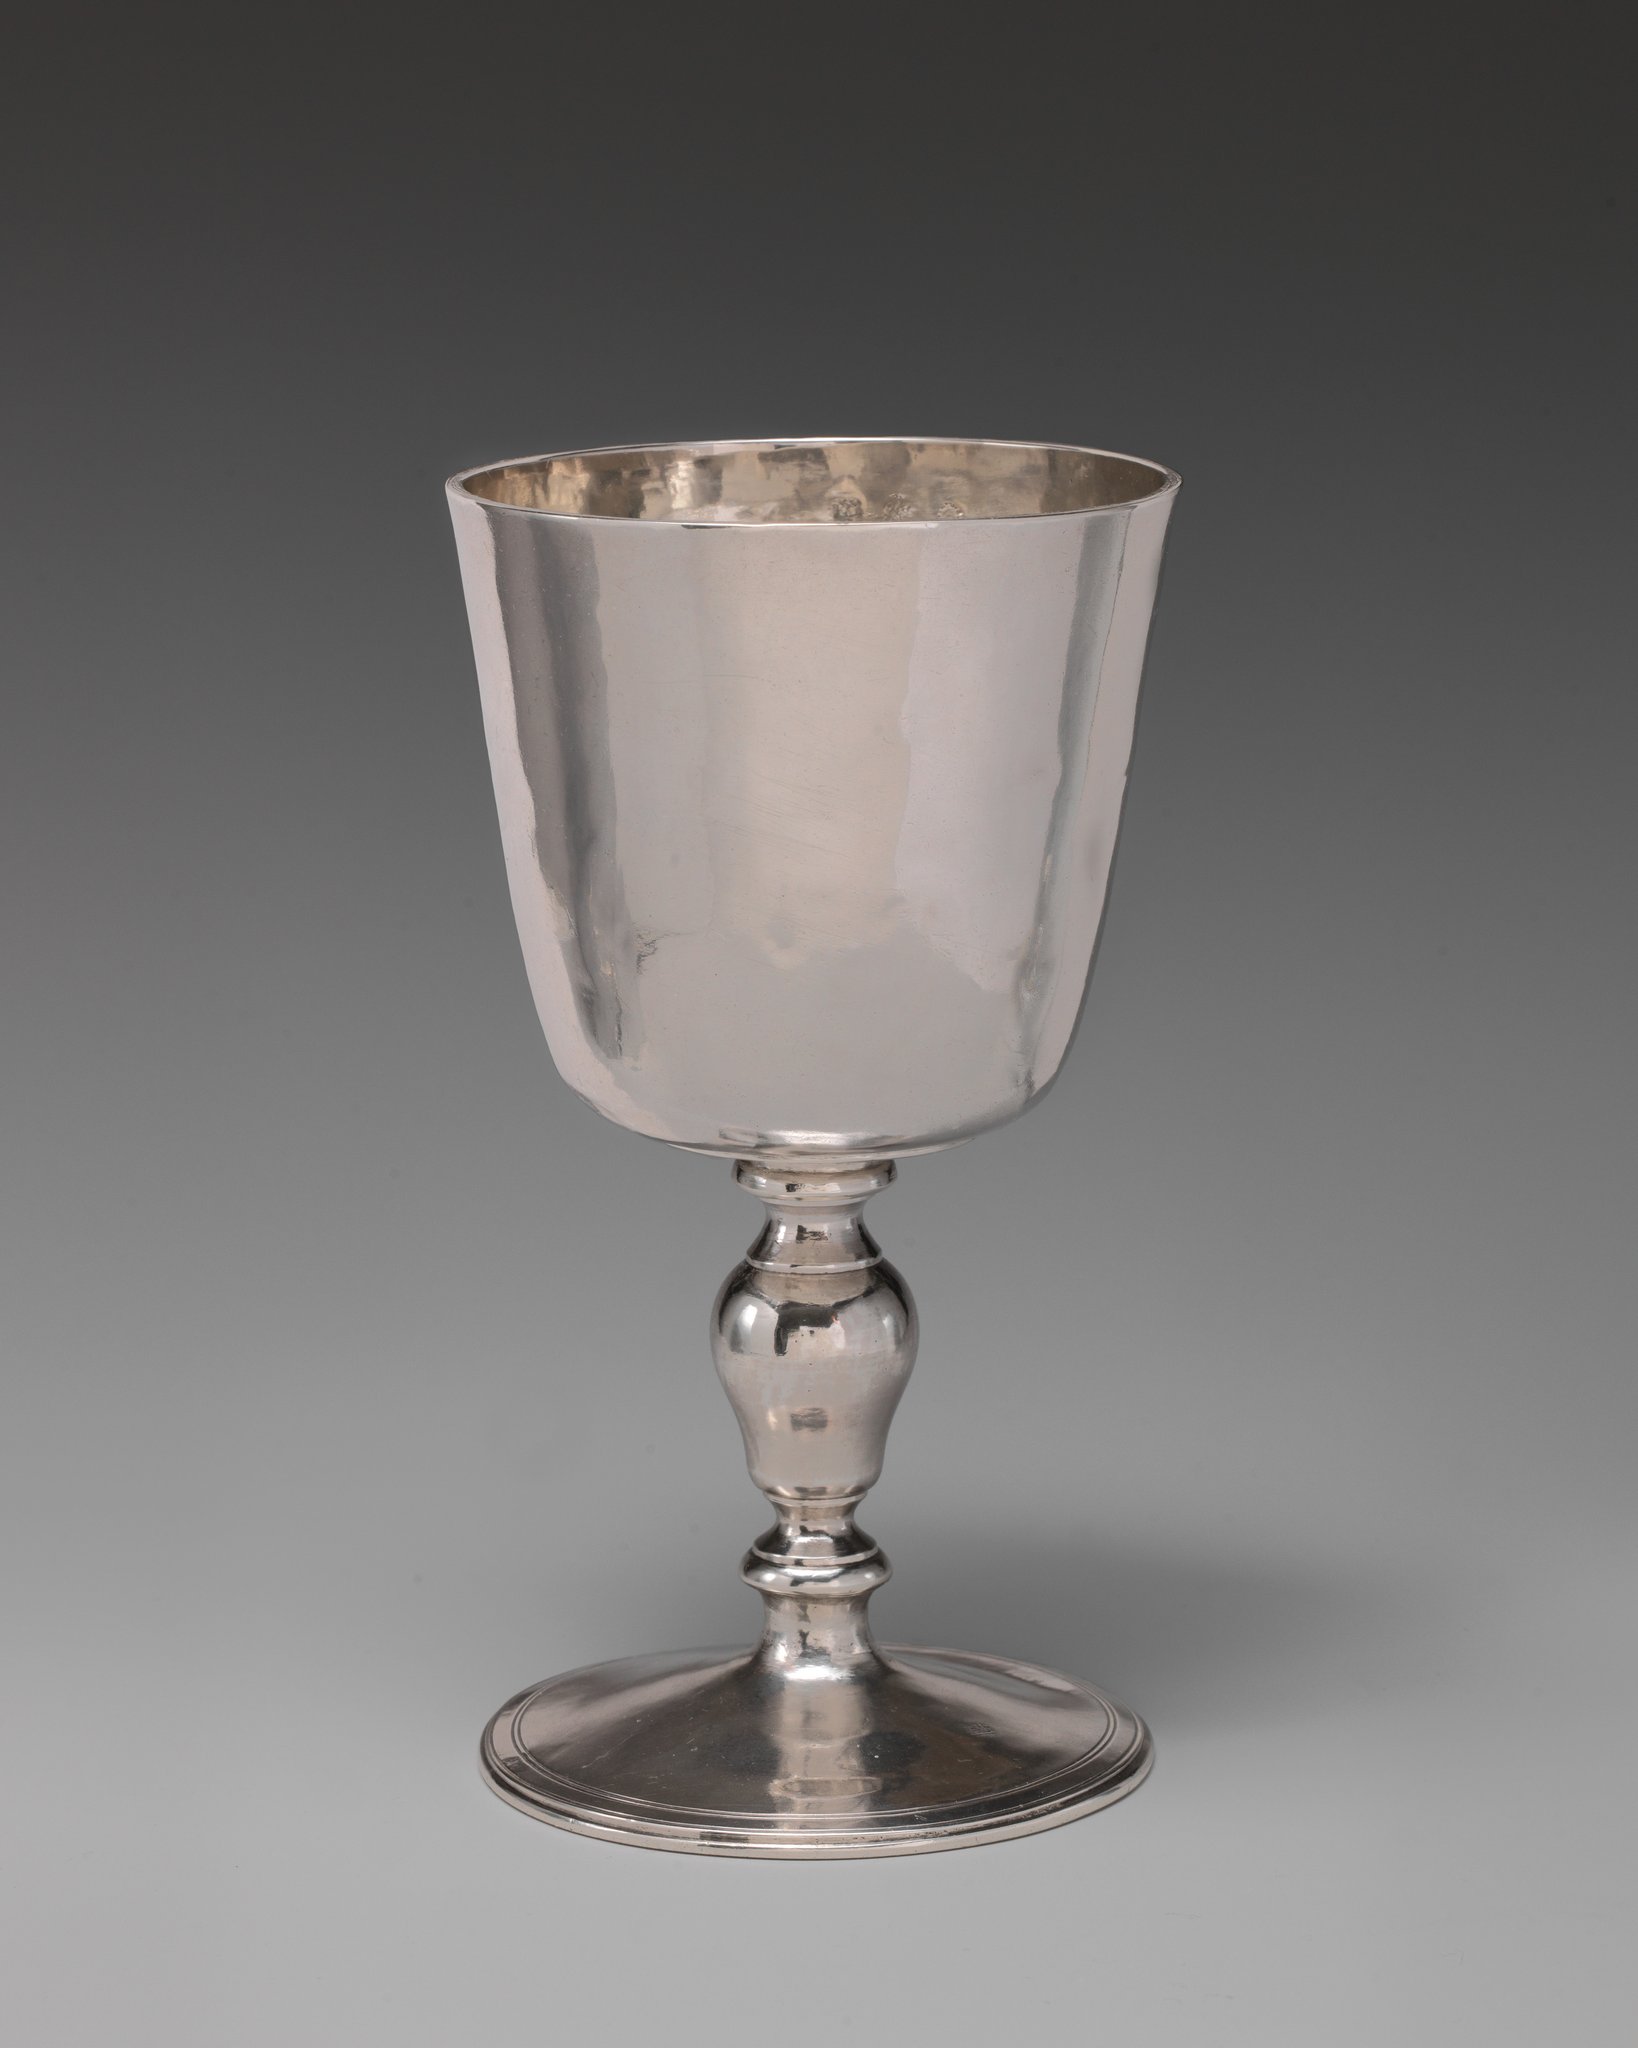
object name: communion cup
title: Communion cup (one of two)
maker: i t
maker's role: maker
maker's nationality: british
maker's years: 1600-1650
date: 1631-1632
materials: silver